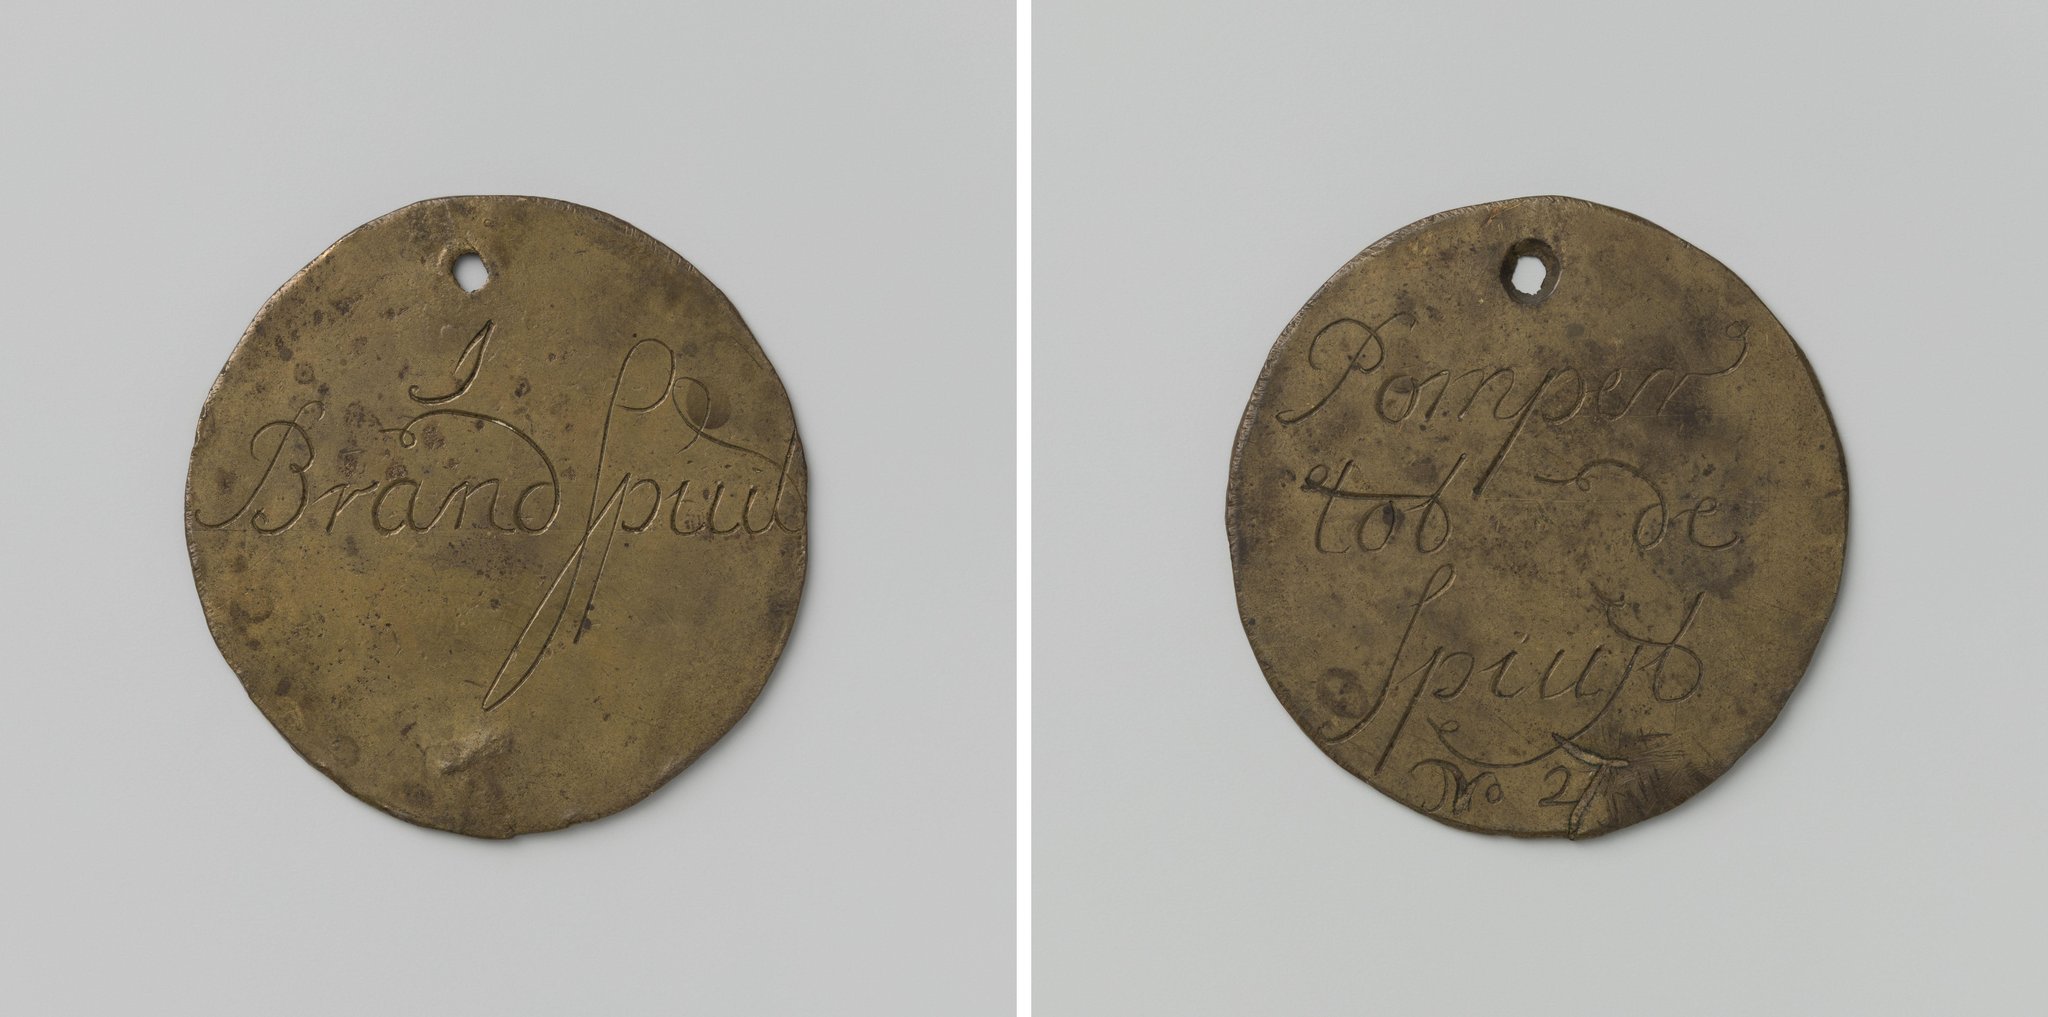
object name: medal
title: Onbekende plaats, brandspuitpenning van spuit 1 met no. 27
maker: Anonymous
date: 1680-1800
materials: brass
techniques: engraving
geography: netherlands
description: Messing penning met gat erin. Voorzijde: opschrift. Keerzijde: opschrift boven cijfer No. 2, waarachter cijfer 7 is gegraveerd